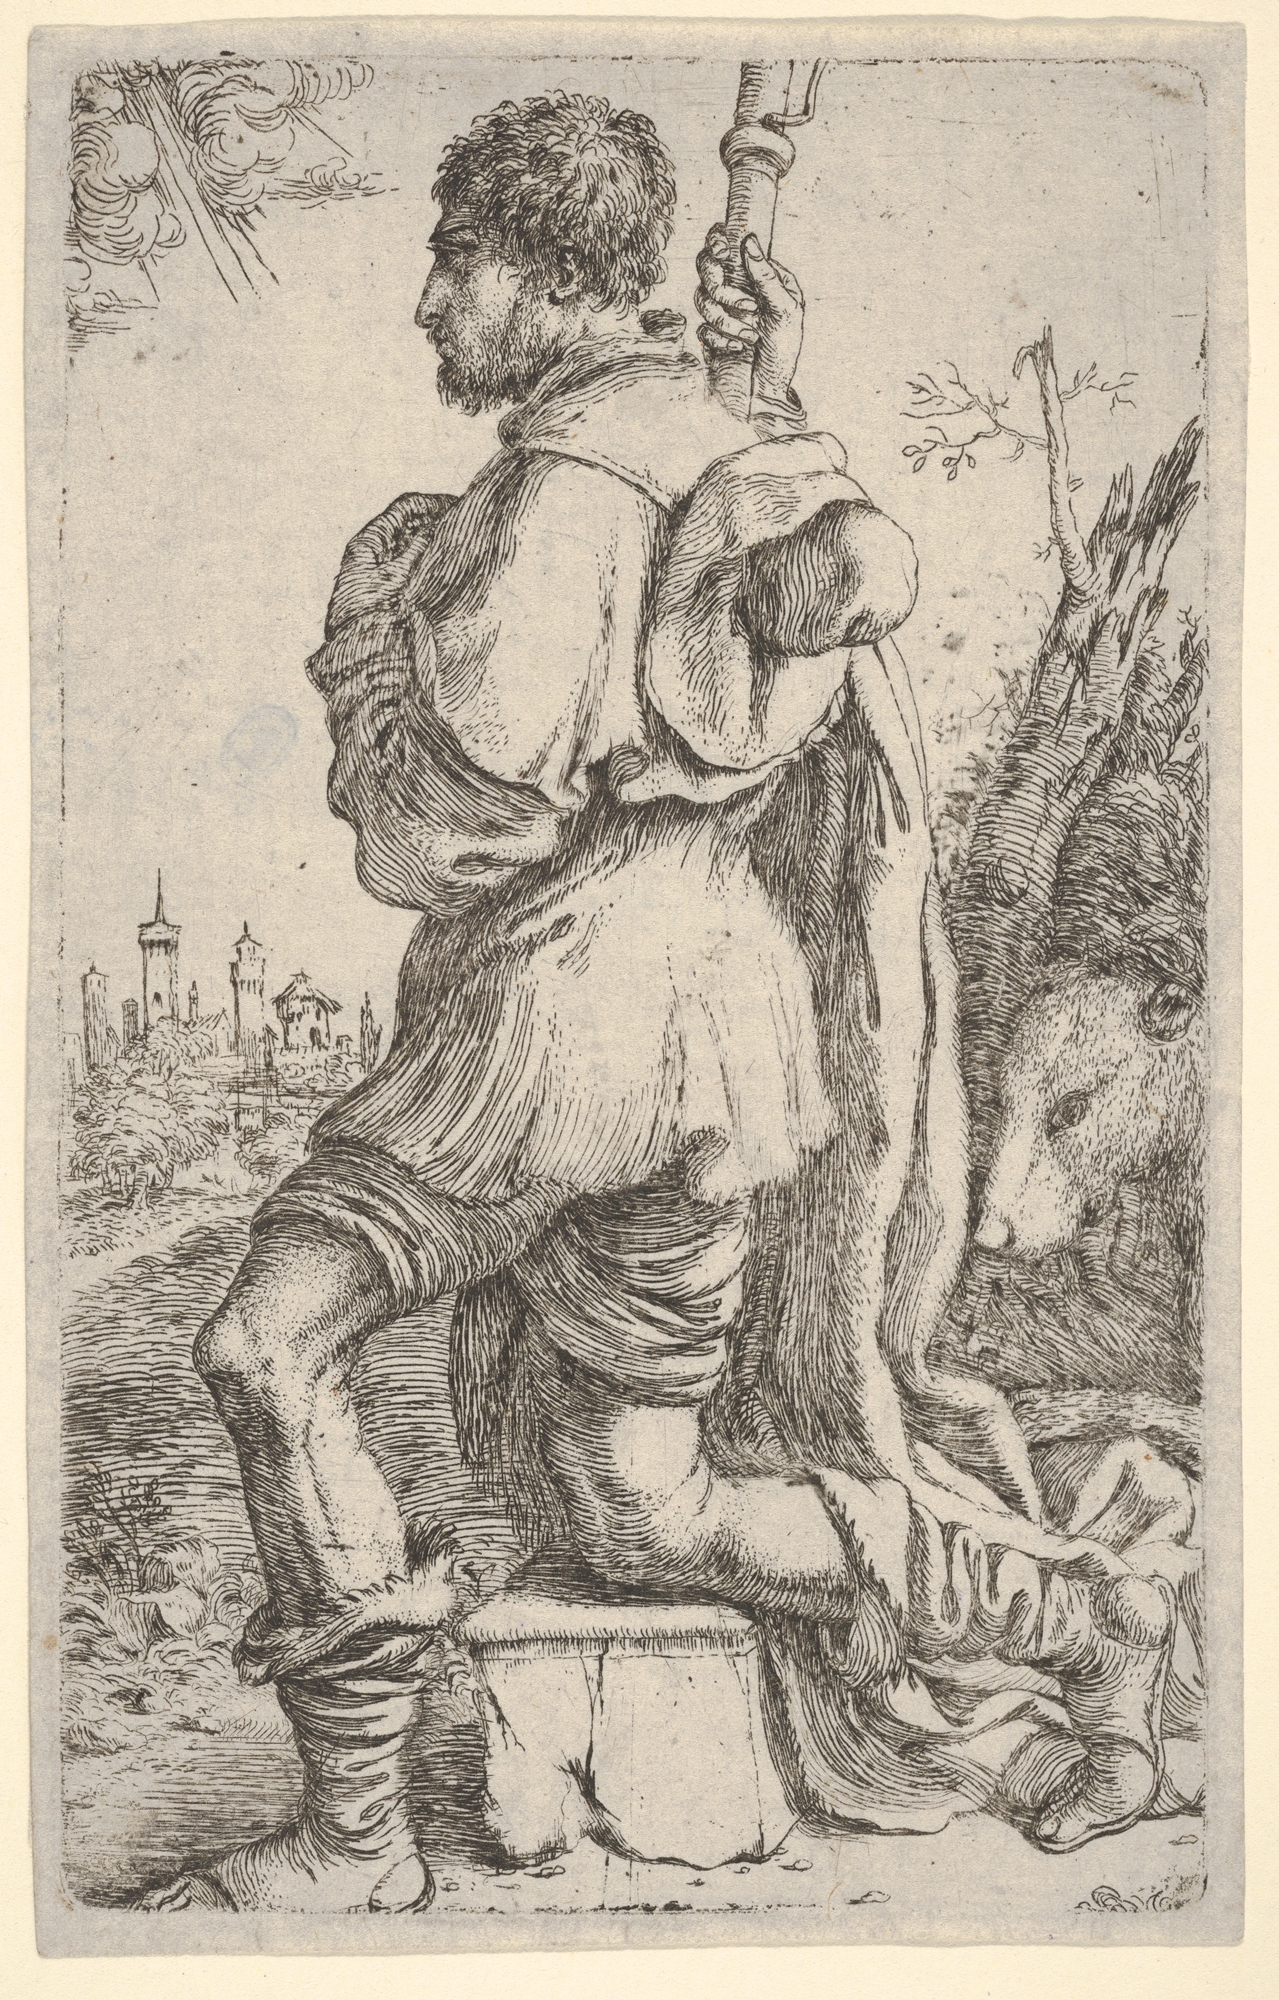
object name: print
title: Saint Roch, kneeling on a stone, seen from the side with his dog behind him and a townscape in the background at left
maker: giuseppe caletti, called cremonese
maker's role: artist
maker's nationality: italian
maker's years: 1600-1660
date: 1620-1630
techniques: etching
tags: men,saints